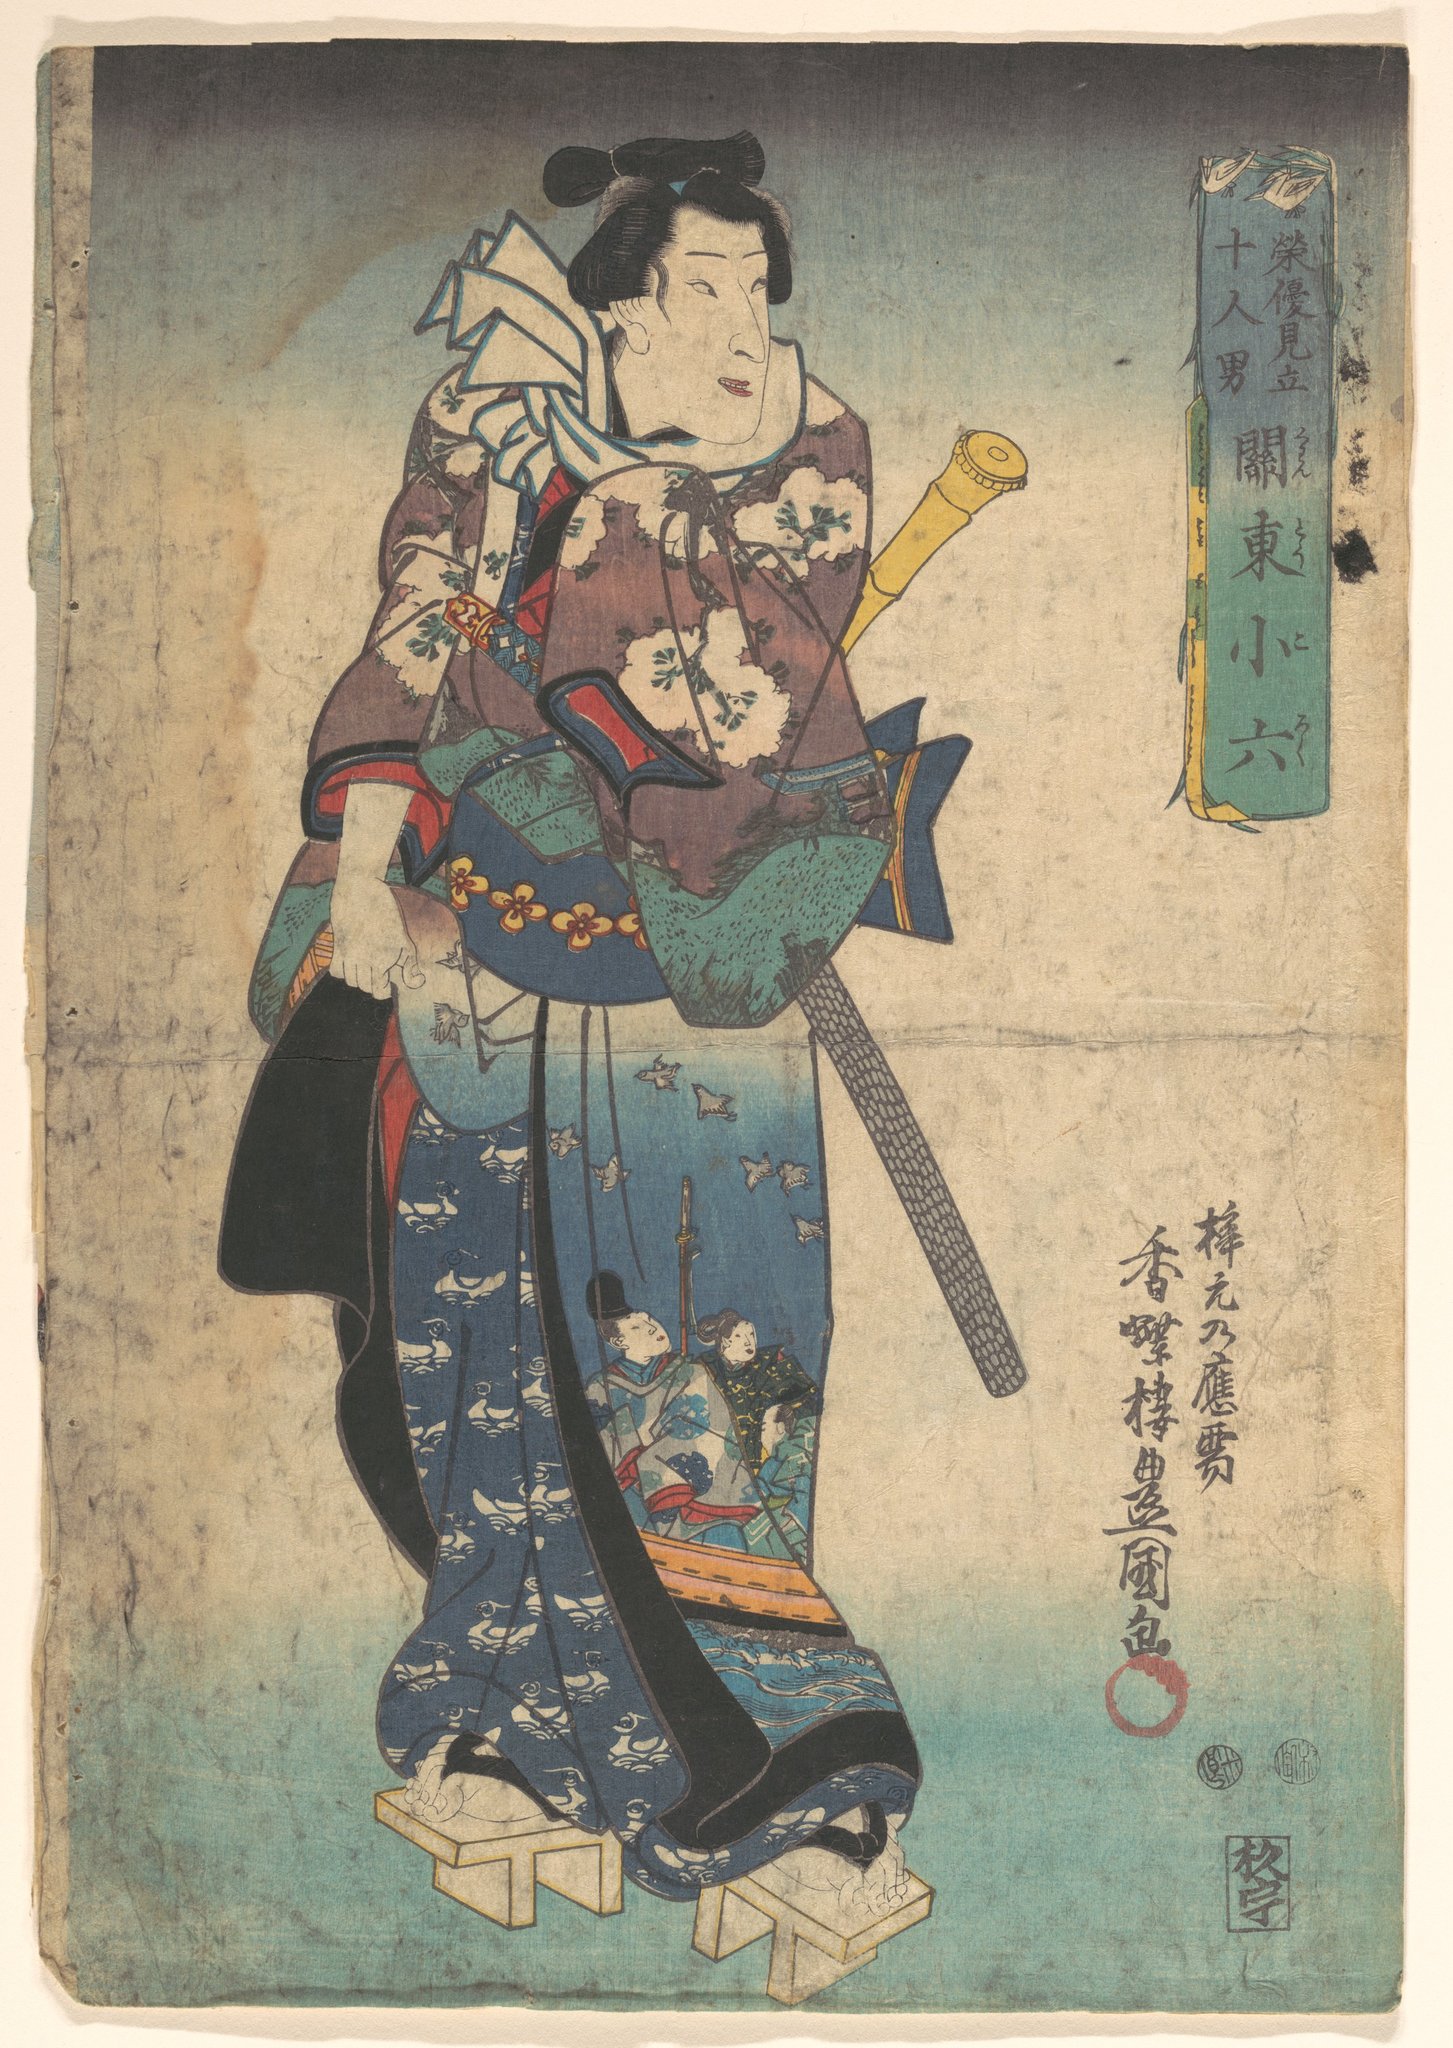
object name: print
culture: japanese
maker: utagawa kunisada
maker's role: artist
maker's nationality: japanese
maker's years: 1786-1864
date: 1801-1900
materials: ink, paper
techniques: woodblock print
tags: human figures,swords